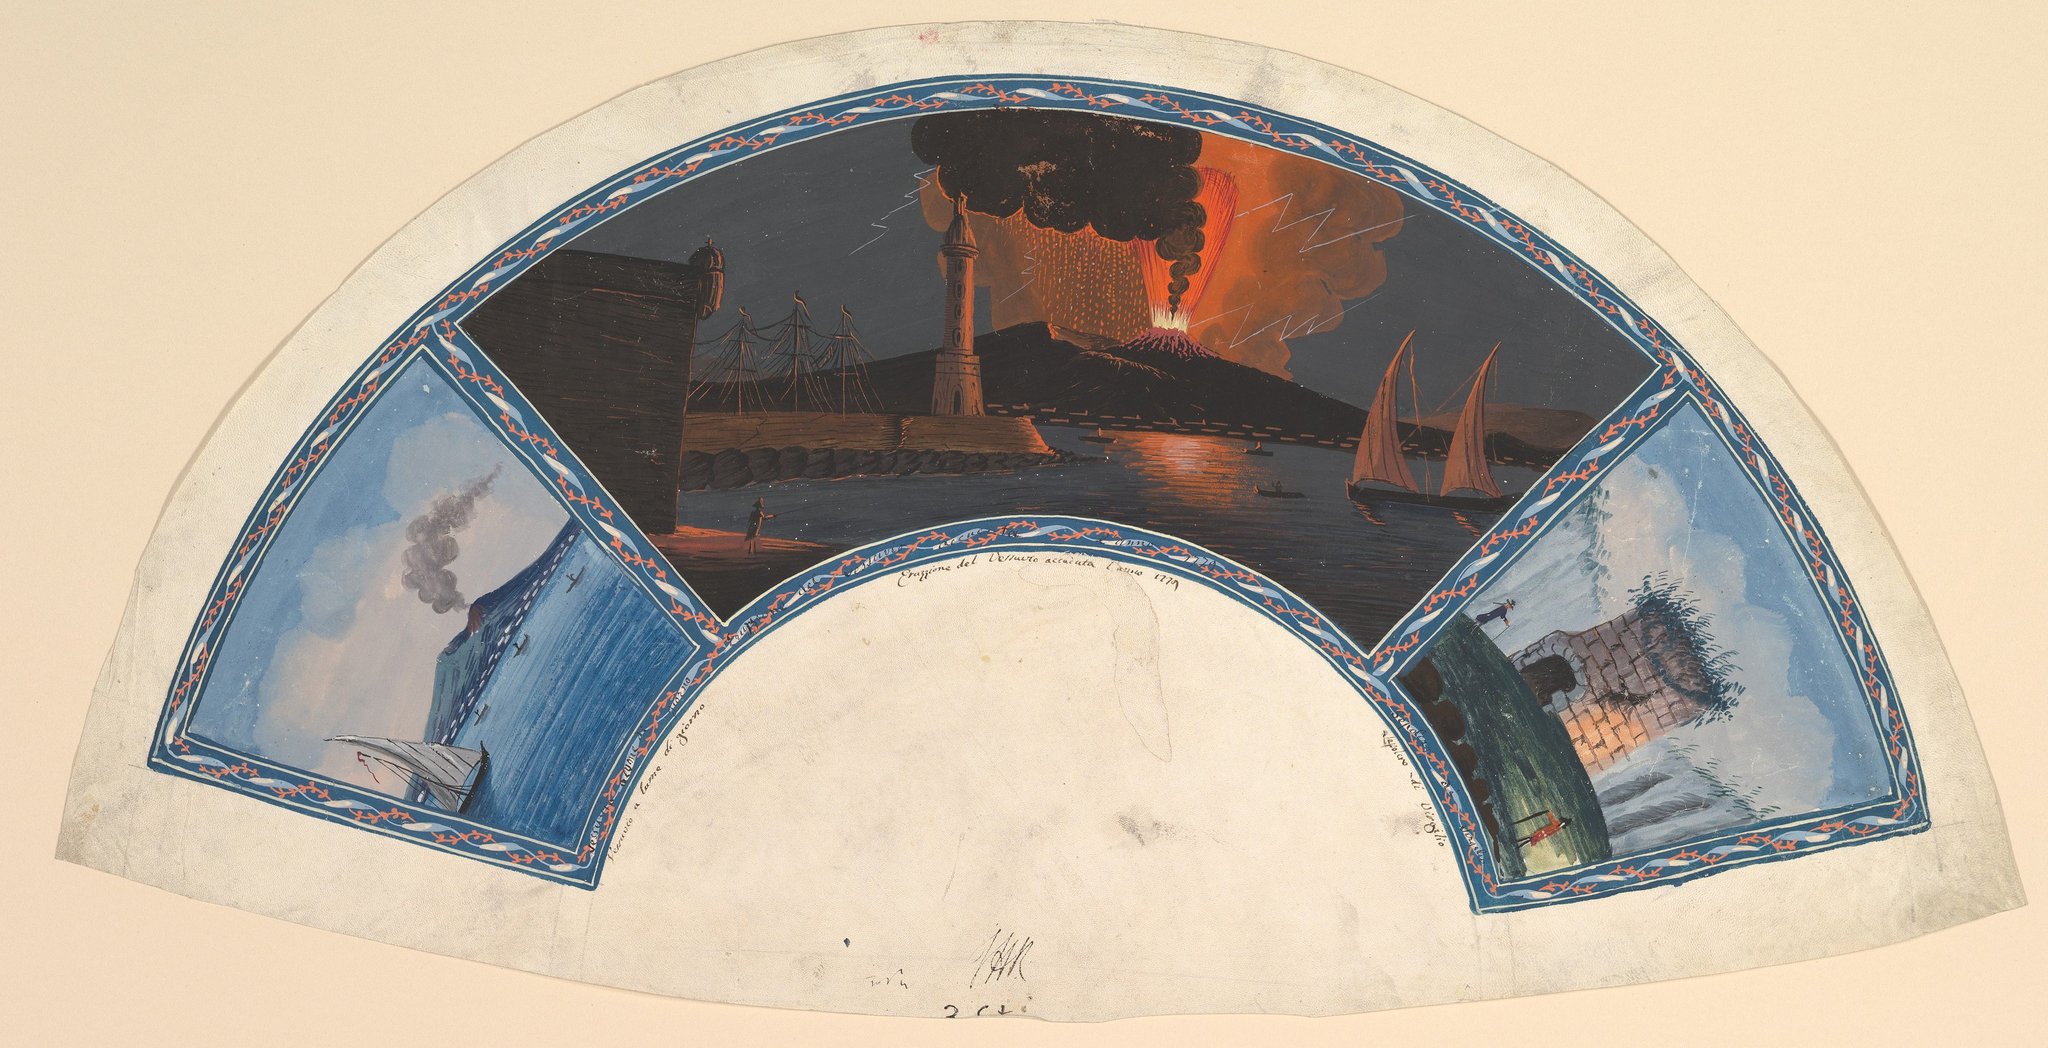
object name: drawing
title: Fan Design with Views of Mount Vesuvius and the Tomb of Virgil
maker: anonymous, italian, 18th century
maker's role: artist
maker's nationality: italian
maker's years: 1700-1800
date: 1779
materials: parchment, watercolor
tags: tombs,fans,volcanoes,boats